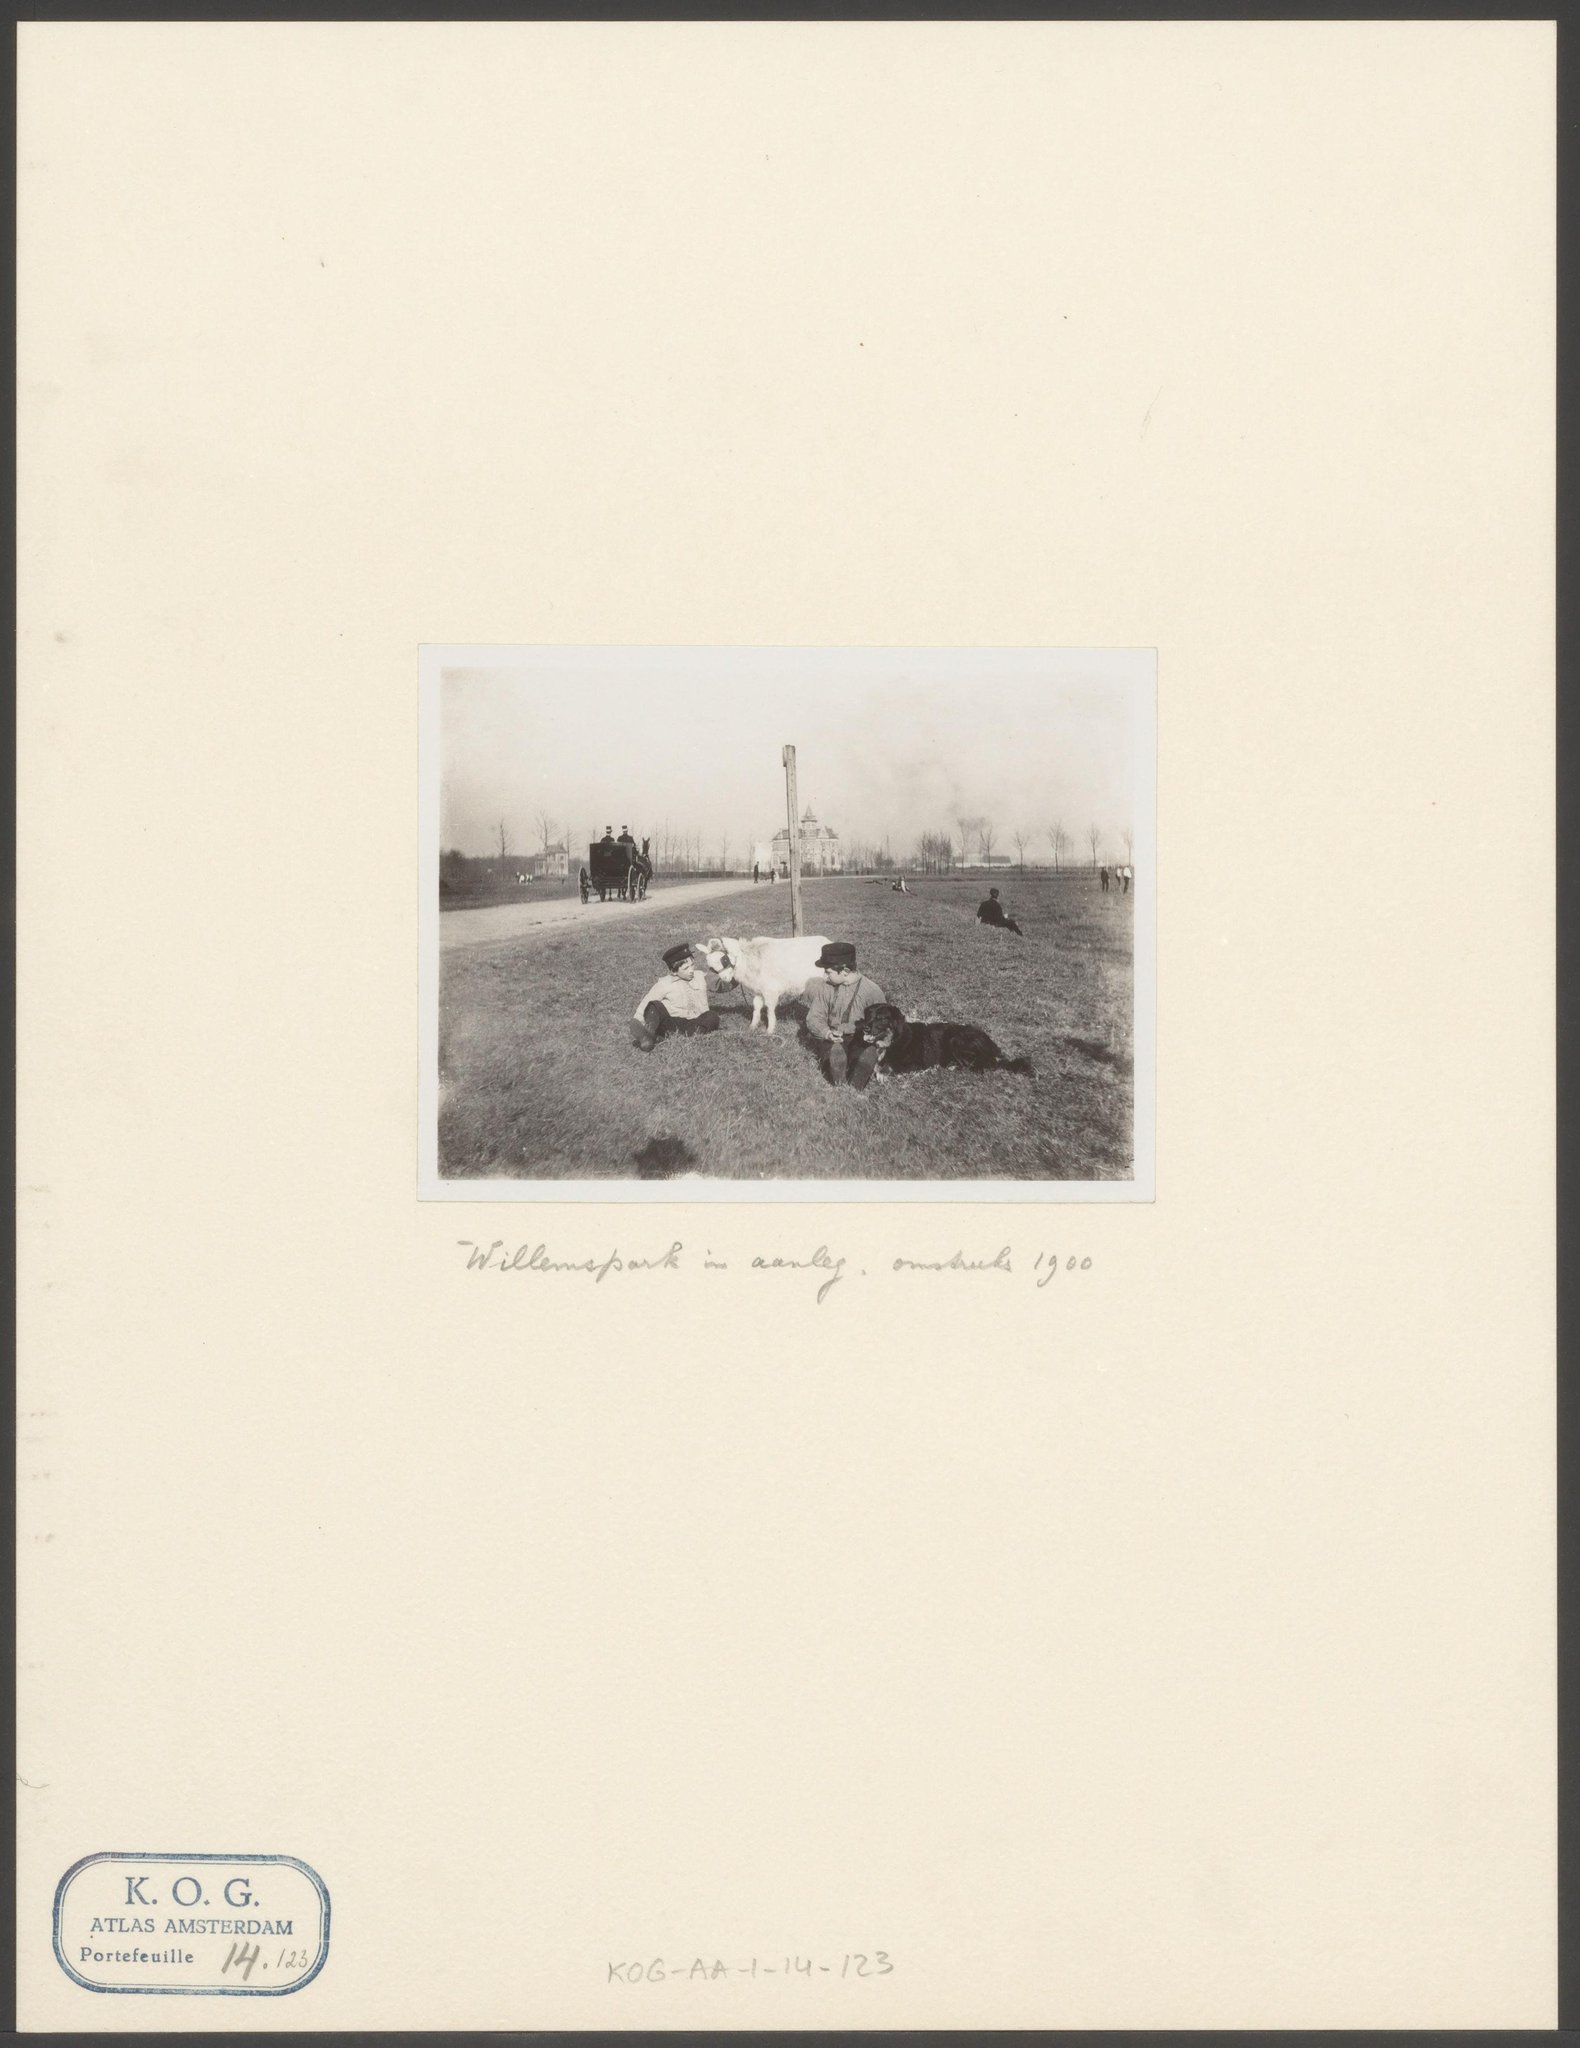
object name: photograph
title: Gezicht op het Willemspark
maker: Anonymous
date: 1900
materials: paper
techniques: gelatin silver print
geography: amsterdam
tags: park, city-view in general; 'veduta'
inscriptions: collector's mark: ‘14.123’ Lugt 1641b, inscription: ‘Willemspark in aanleg. omstreeks 1900’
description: Onderwerpsrubriek binnen de Atlas Amsterdam: Waal (Kromme en Oude), Walenpleintje, Warmoesgracht, Warmoesstraat, Waterlooplein, Westerdoksdijk, Westermarkt, Weteringschans, Willemspark, Willemsstraat, Wittenburg, Wittenkade (de), Wittenstraat (de).